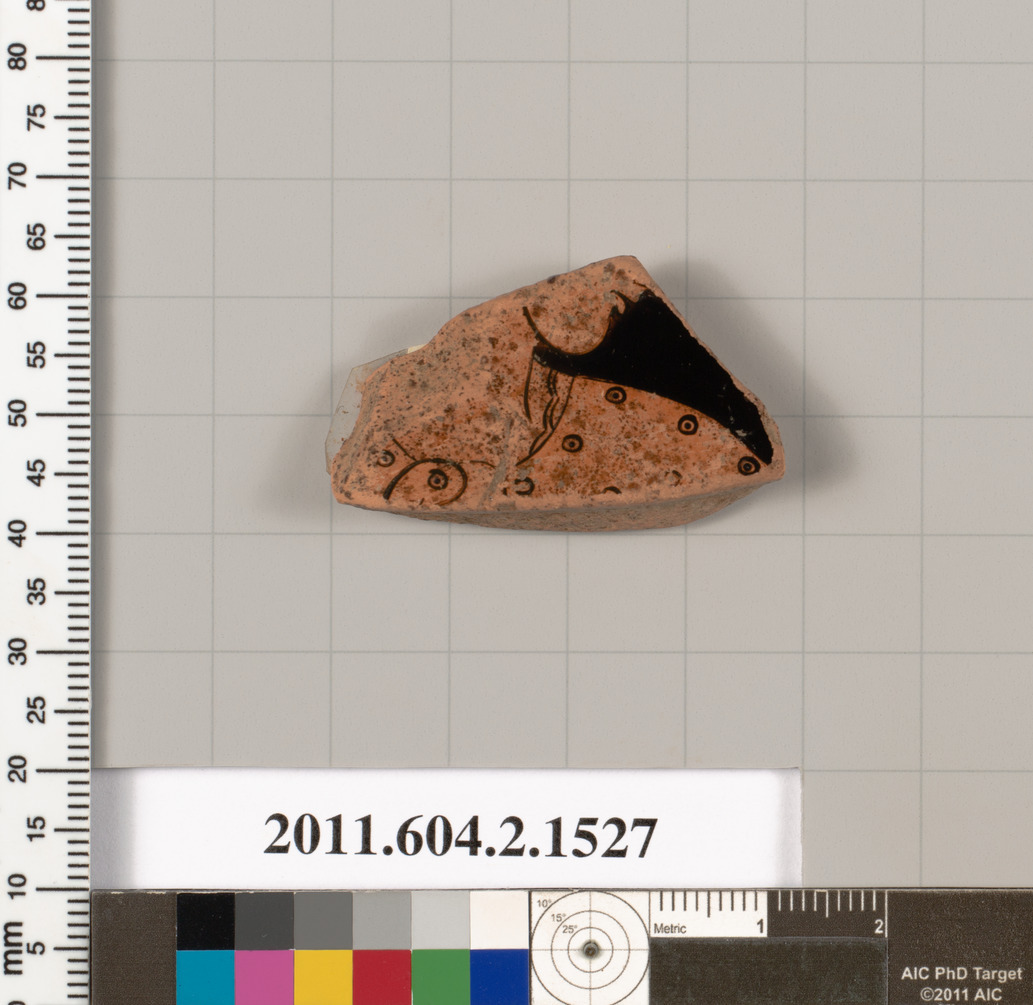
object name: skyphos fragment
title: Terracotta fragment of a skyphos (deep drinking cup)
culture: greek, attic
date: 500-480 BCE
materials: terracotta